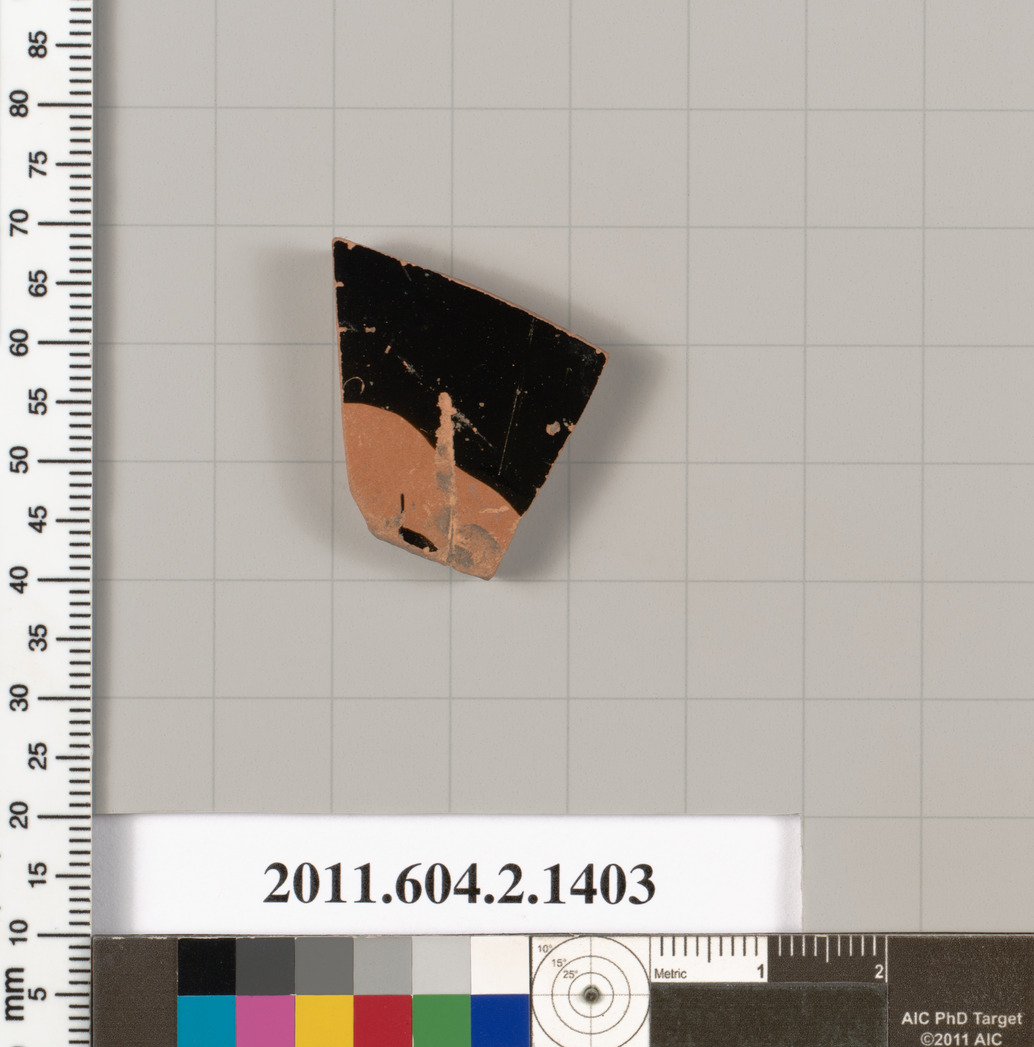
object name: skyphos fragment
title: Terracotta fragment of a skyphos (deep drinking cup)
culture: greek, attic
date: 475-451 BCE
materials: terracotta